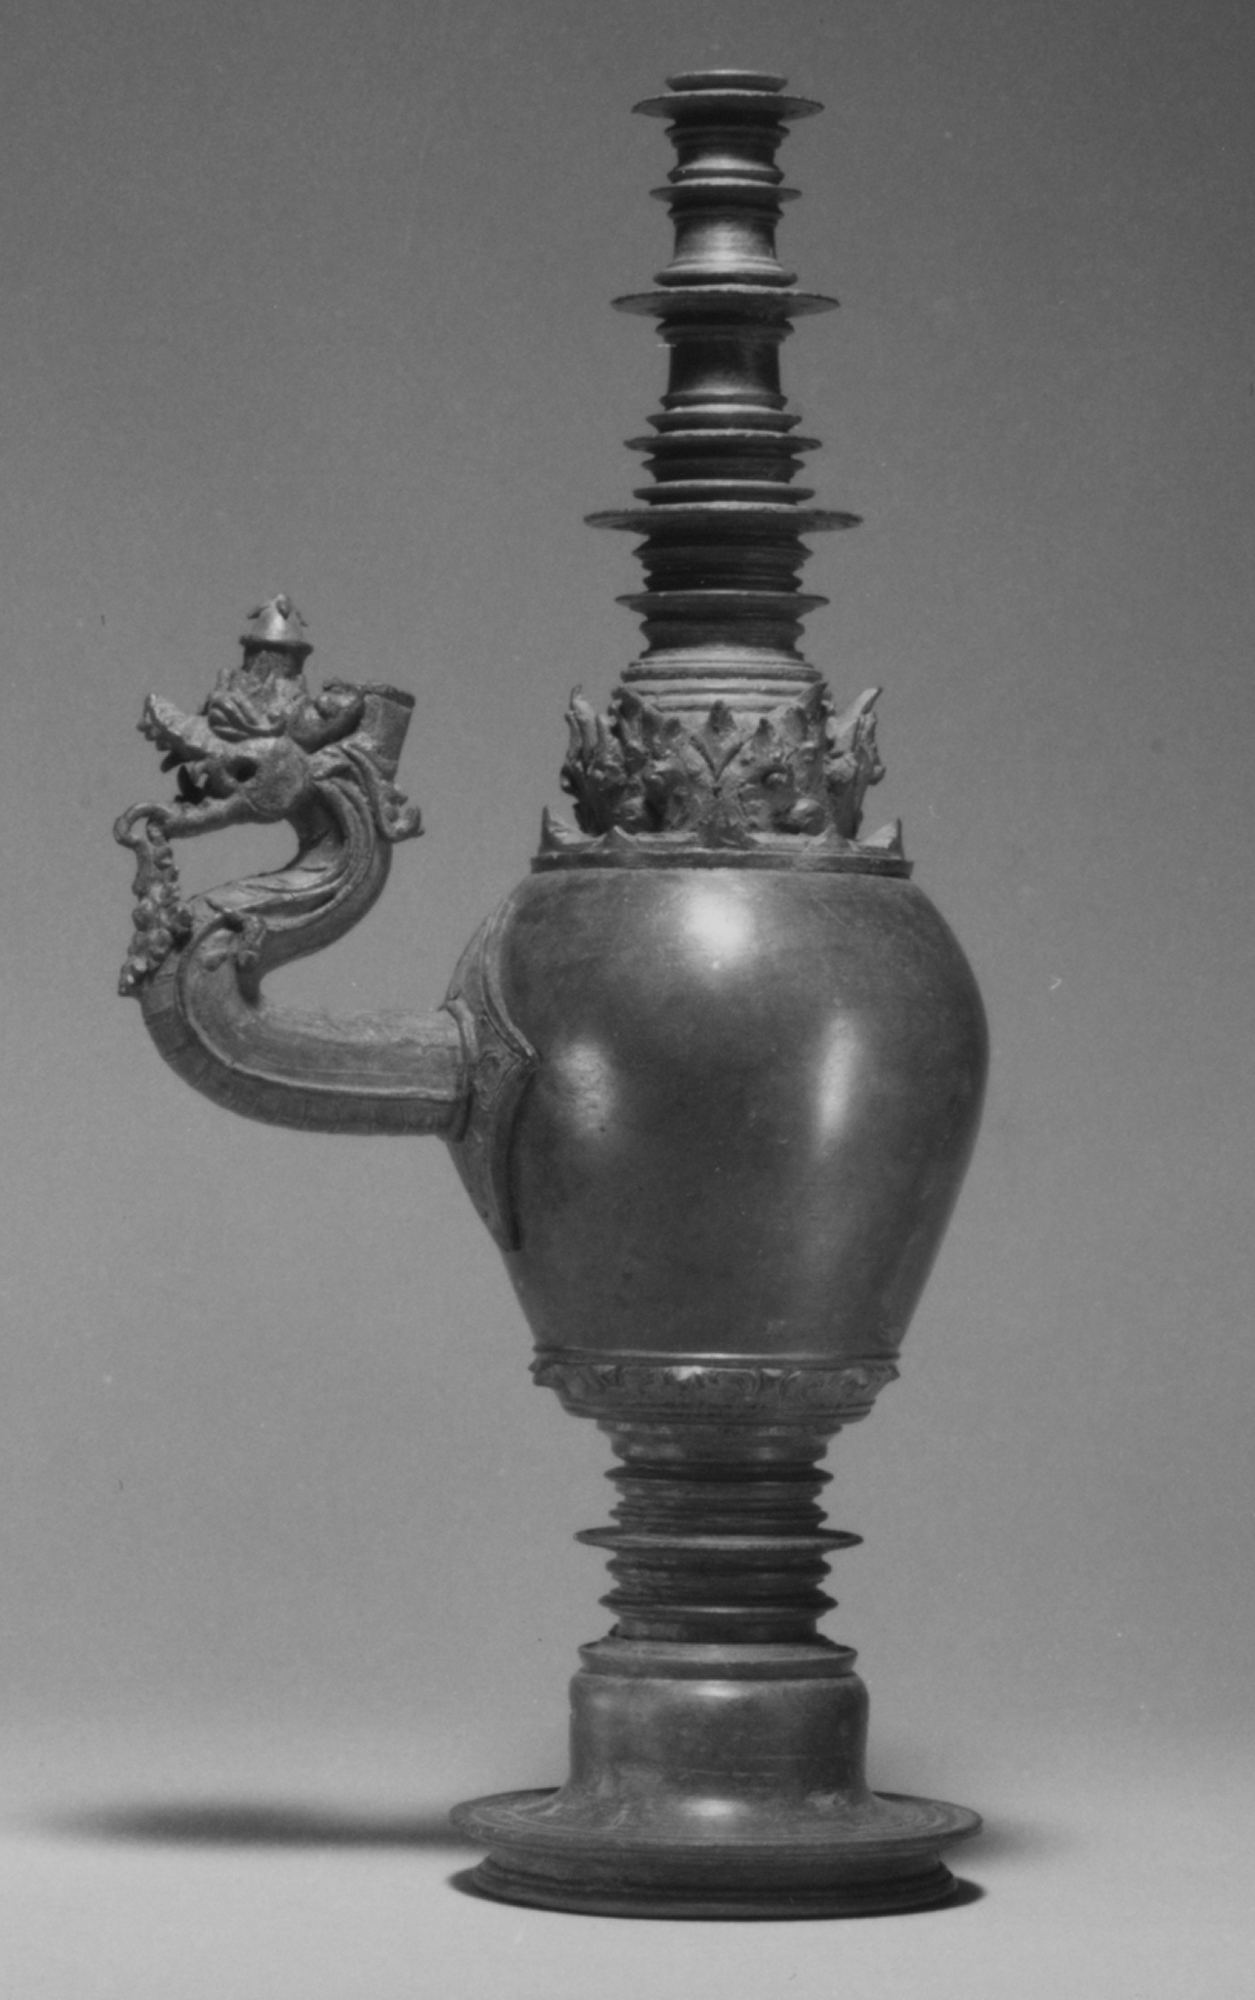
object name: holy water vessel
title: Holy-Water Vessel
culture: indonesian, javanese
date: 1301-1400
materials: bronze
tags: dragons